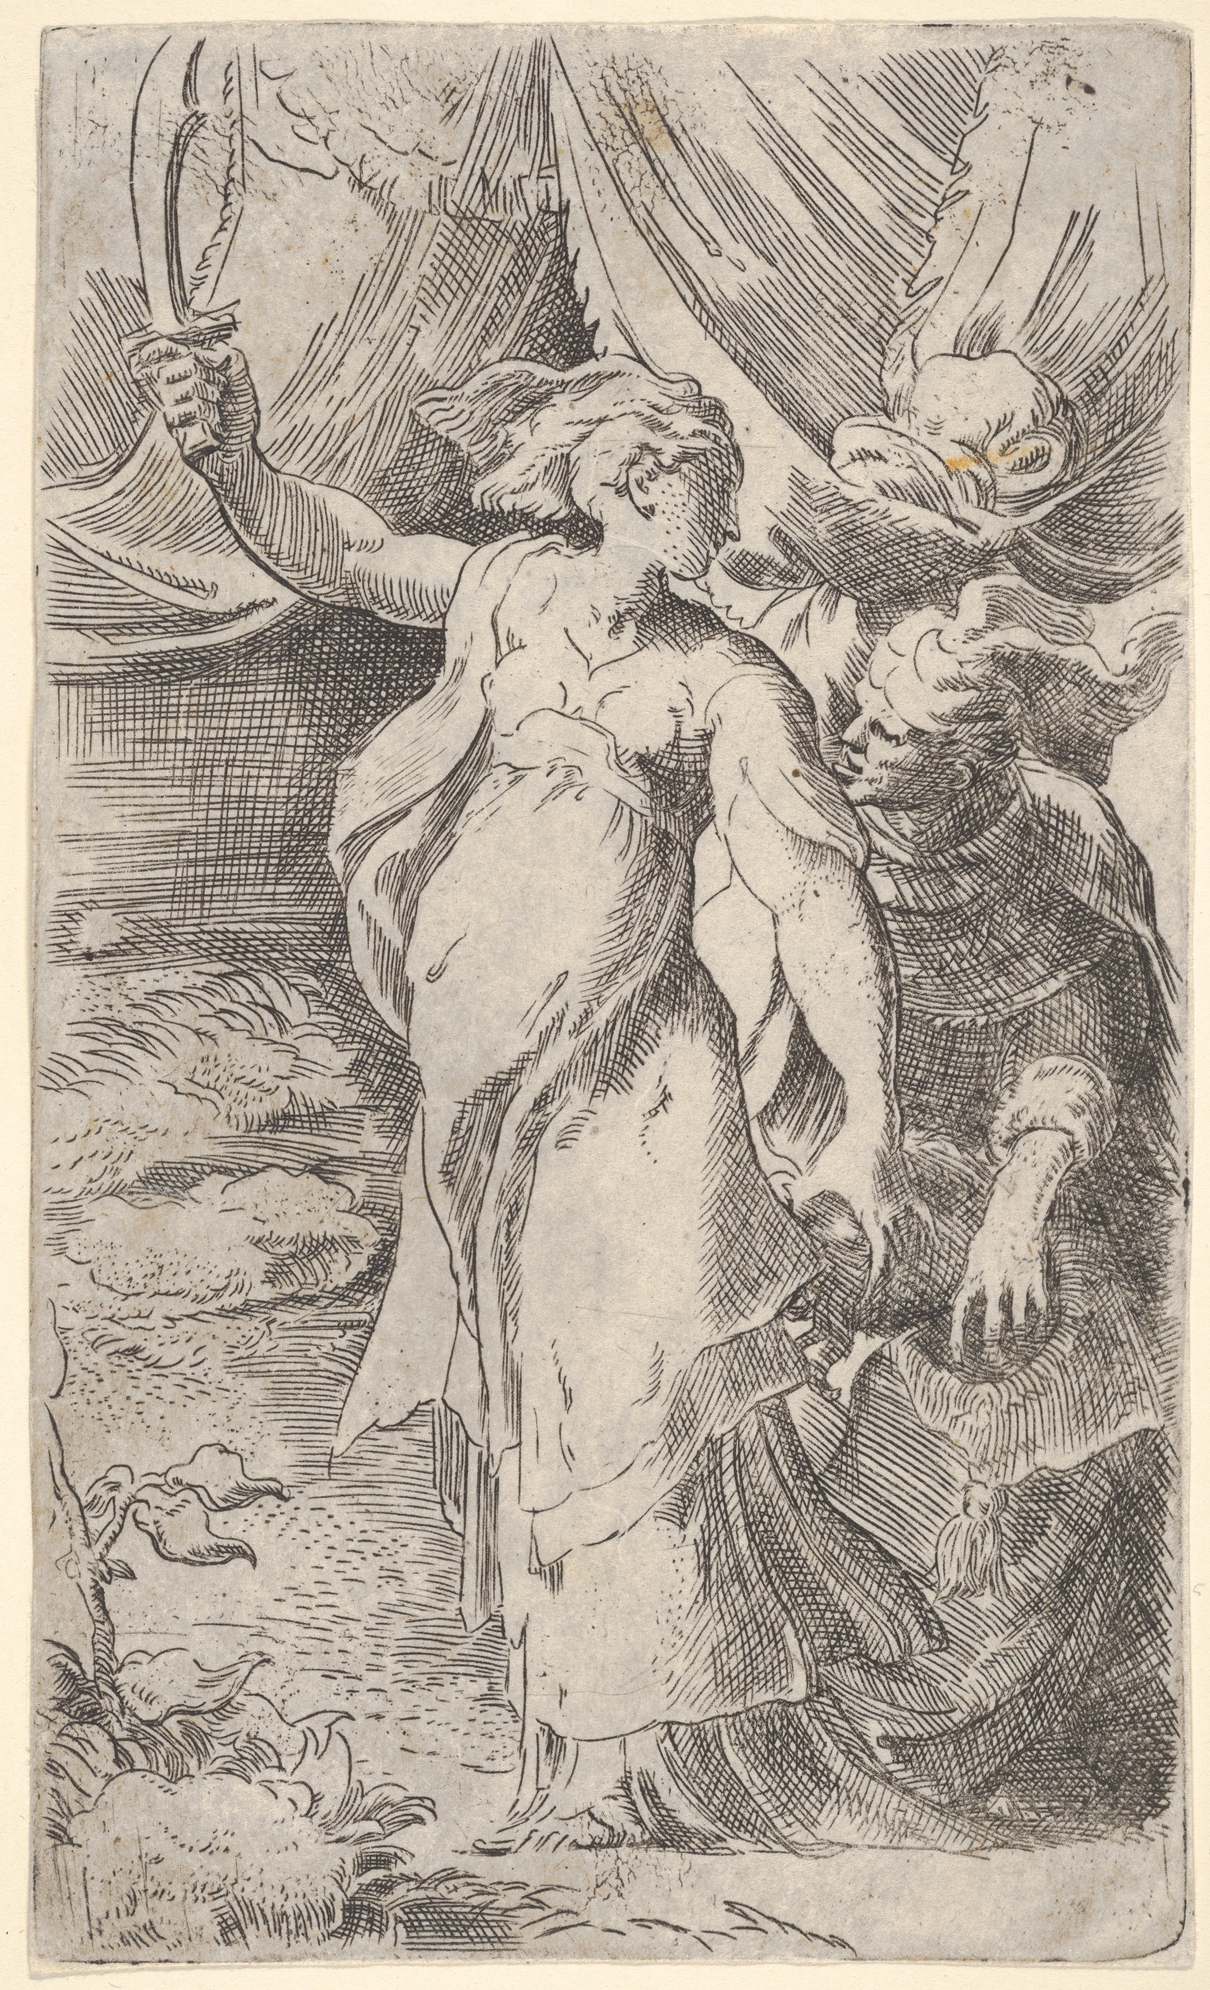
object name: print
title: Judith with the head of Holofernes, which she places into a sack held by the figure behind her, she bears a sword in her outstretched right arm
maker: parmigianino (girolamo francesco maria mazzola)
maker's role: artist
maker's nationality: italian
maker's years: 1503-1540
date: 1520-1540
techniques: engraving, etching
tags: swords,judith